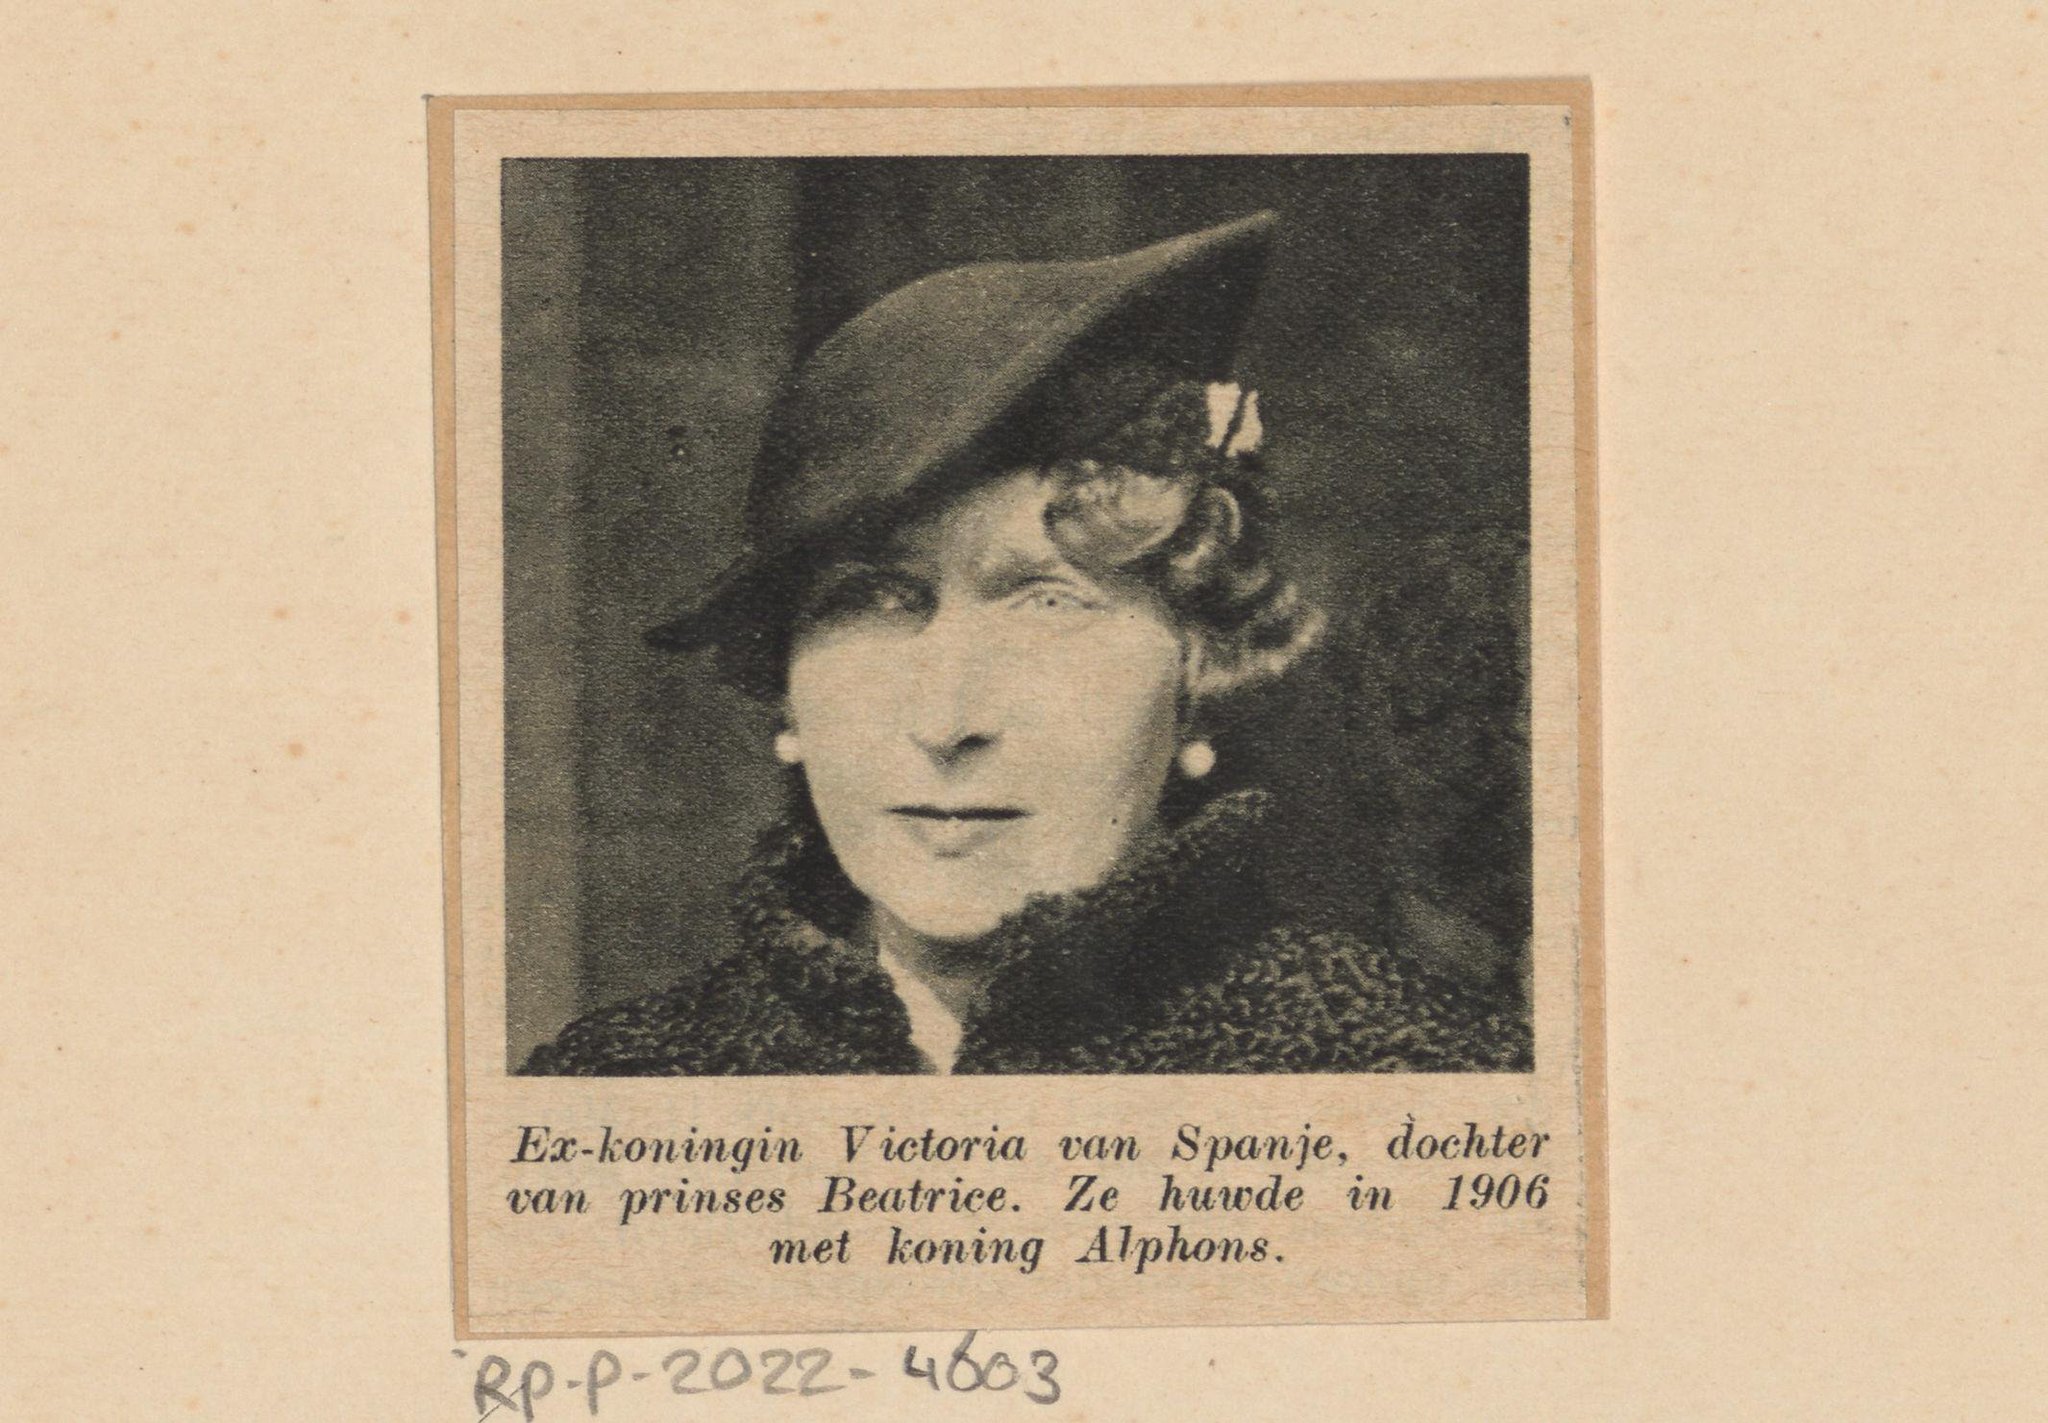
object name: photomechanical print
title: Portret van koningin Victoria Eugénie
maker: Anonymous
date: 1931-1950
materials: paper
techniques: photograph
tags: historical persons - bb - woman, queen